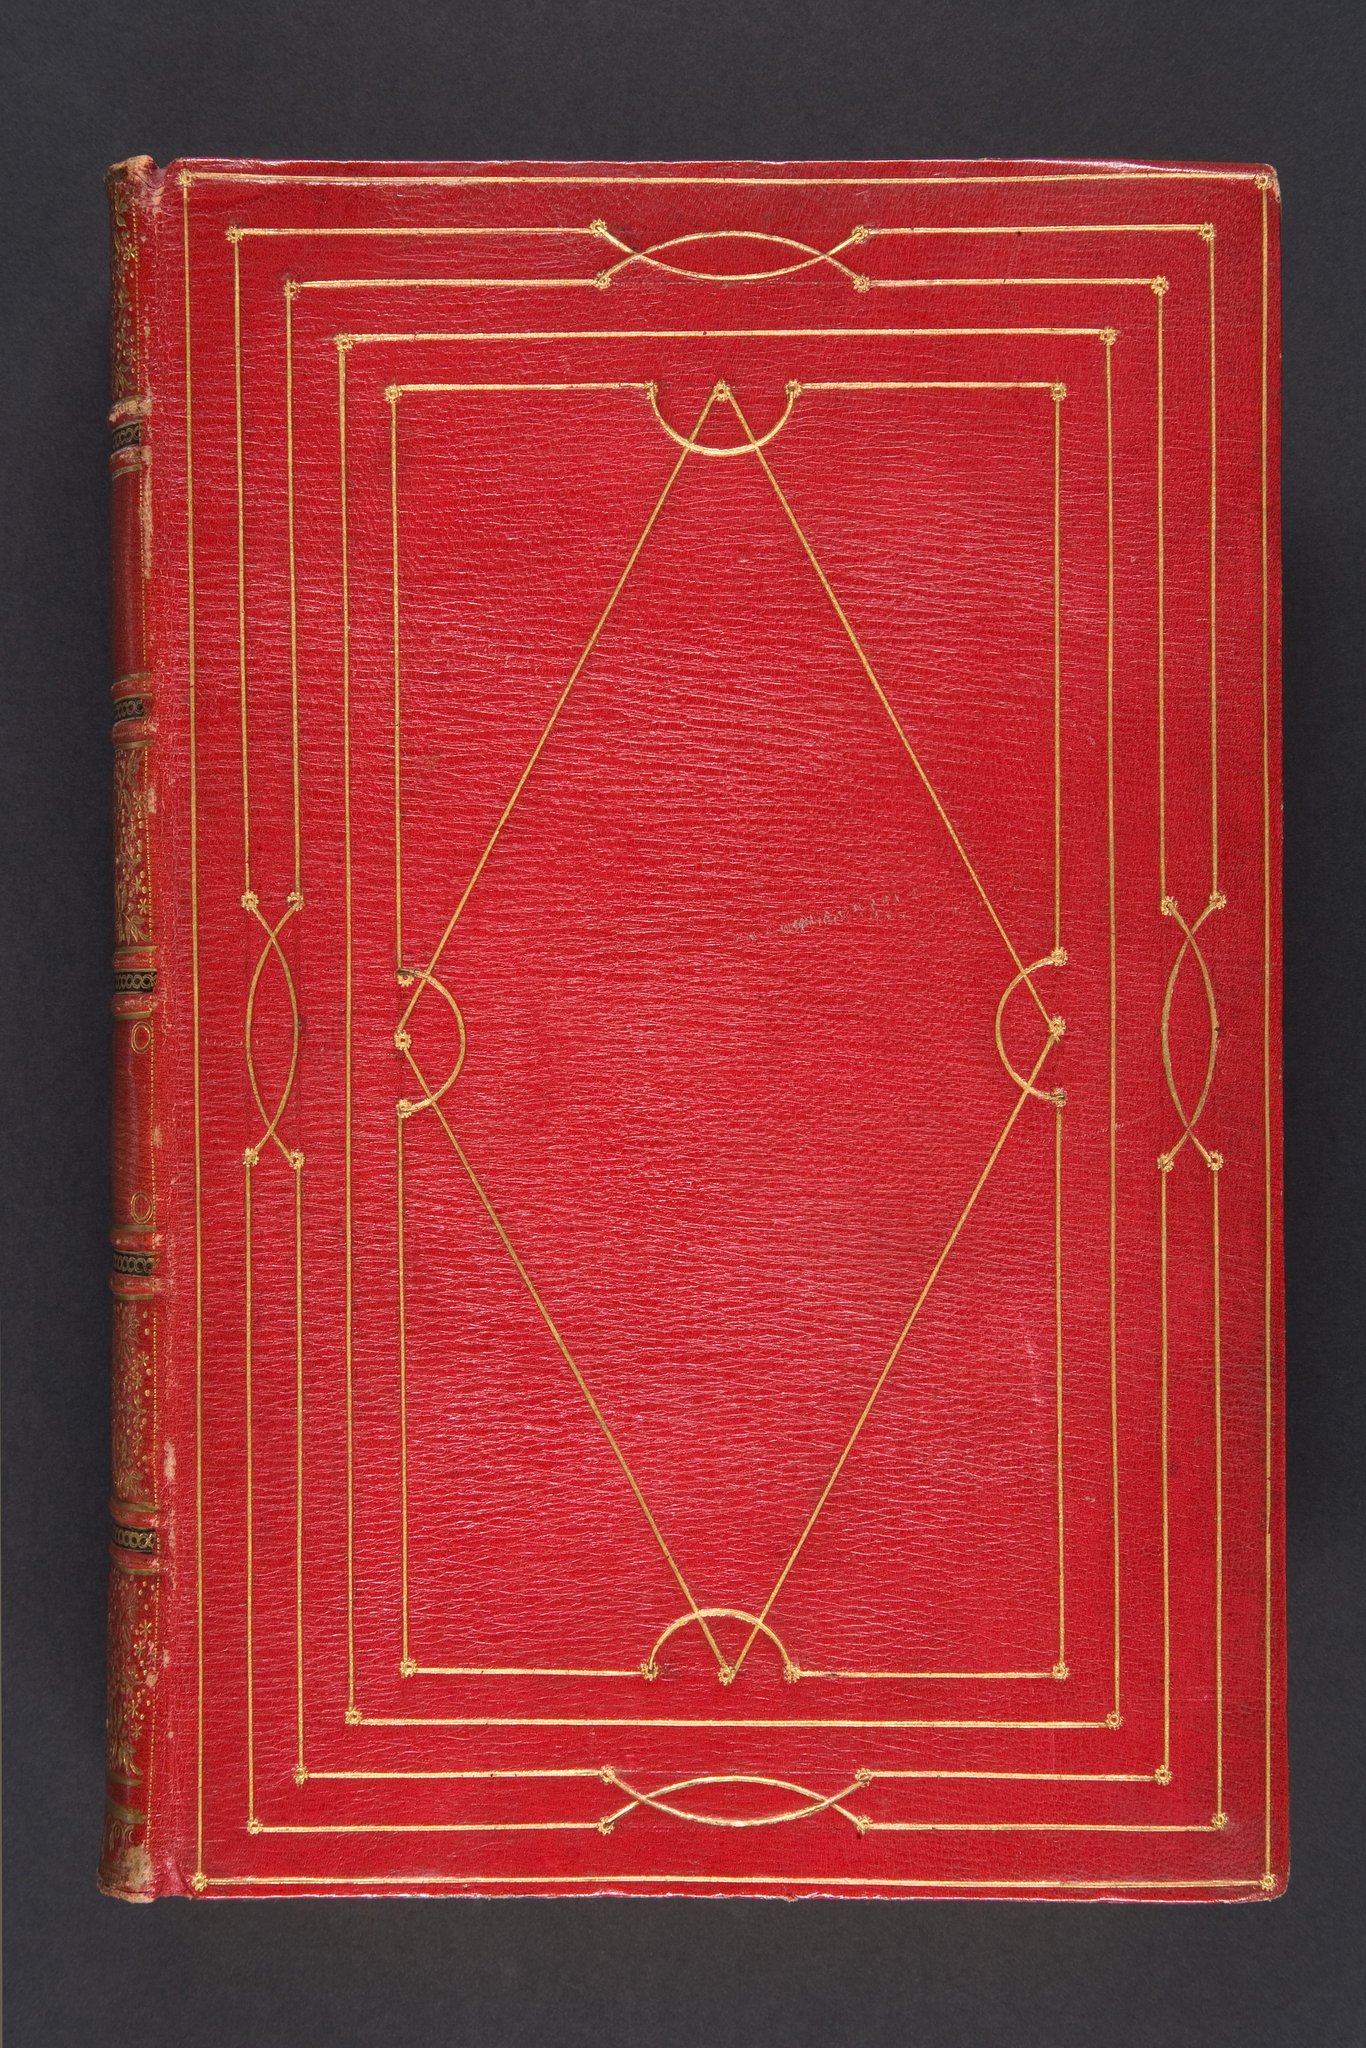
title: Les aventures de Télémaque, fils d'Ulysse par M. de Fénélon ; avec figures en taille-douce, dessinées par MM. Cochin et Moreau le jeune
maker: françois de salignac de la mothe-fénelon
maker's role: author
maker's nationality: french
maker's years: 1651-1715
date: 1790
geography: france